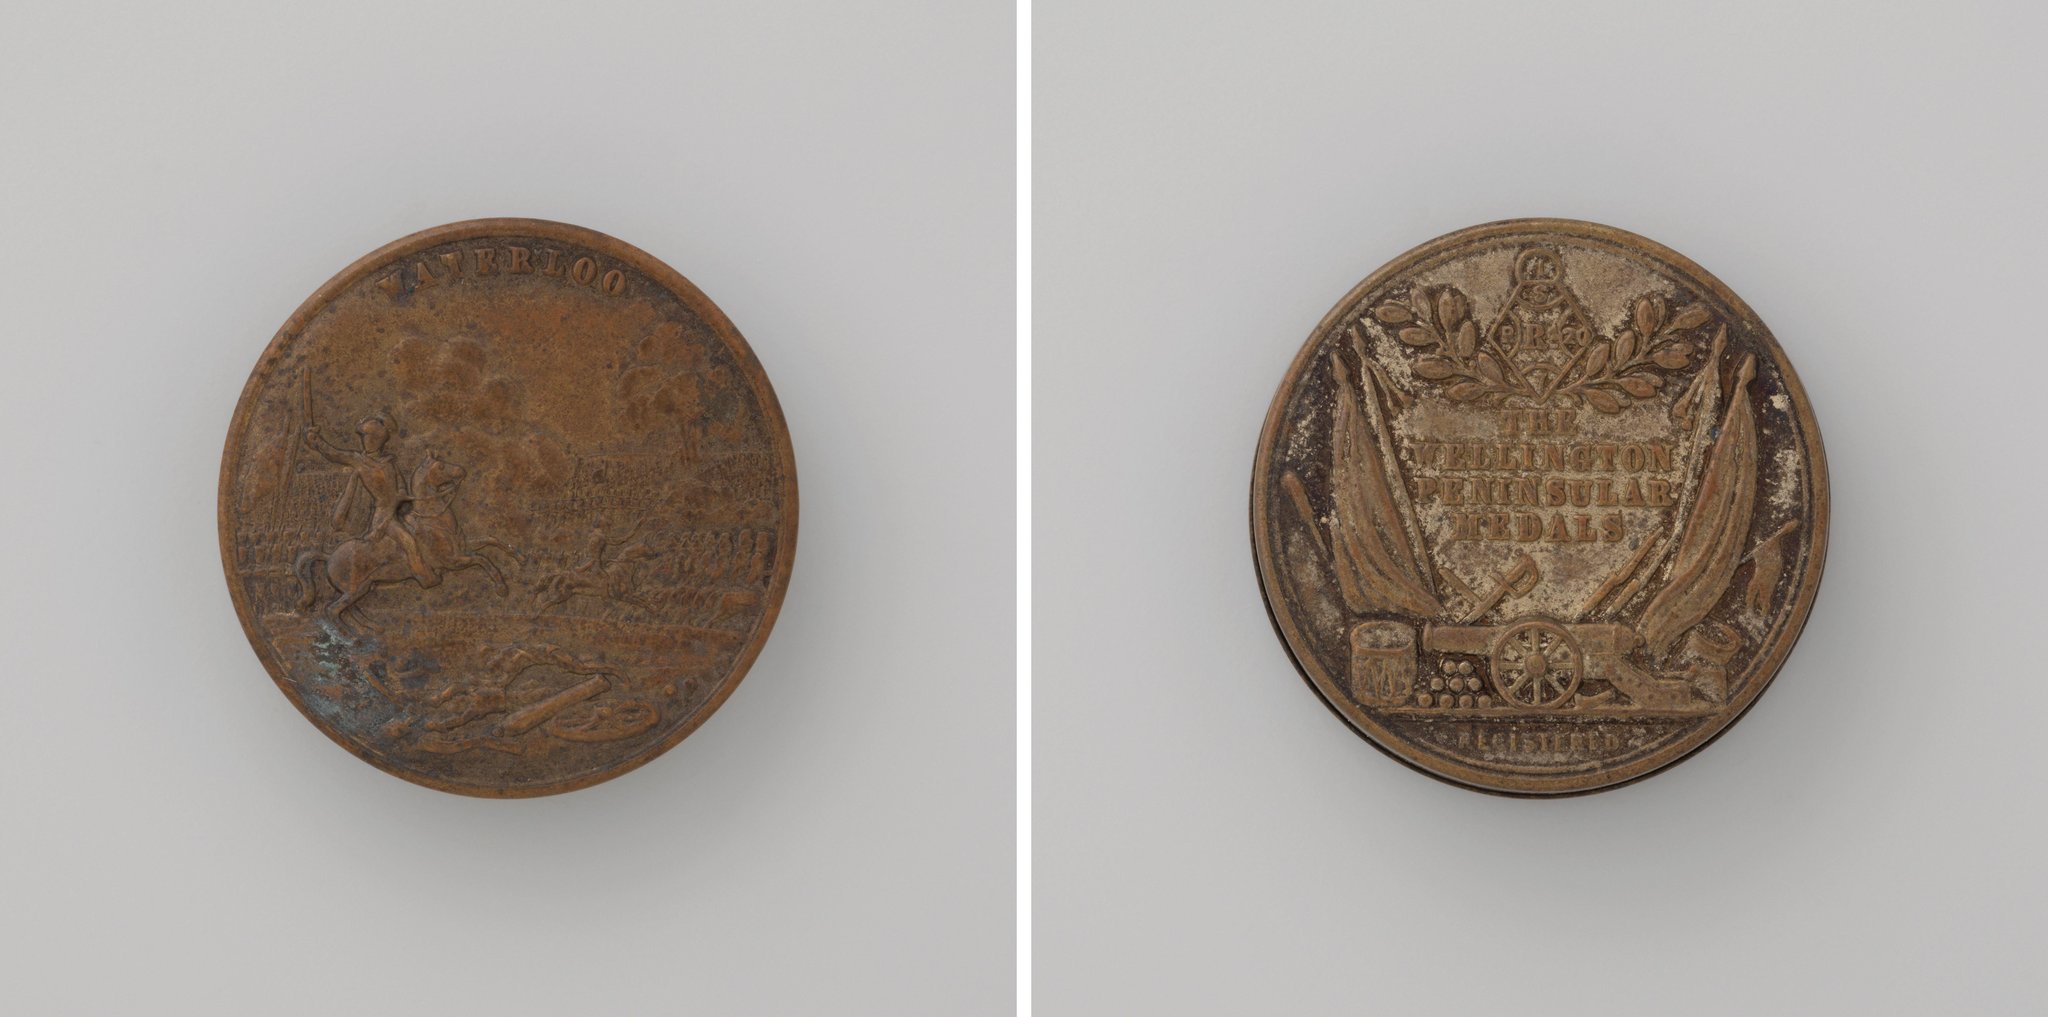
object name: history medal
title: Albert, prins van Saksen-Coburg-Gotha, echtgenoot van Victoria, koningin van Groot-Britannie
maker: Anonymous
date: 1840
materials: copper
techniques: striking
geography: england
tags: victoria (koningin van het verenigd koninkrijk en keizerin van india), albert (prins van saksen-coburg en gotha)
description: Koperen penning. Voorzijde: borstsuk man binnen omschrift. Keerzijde: opschrift